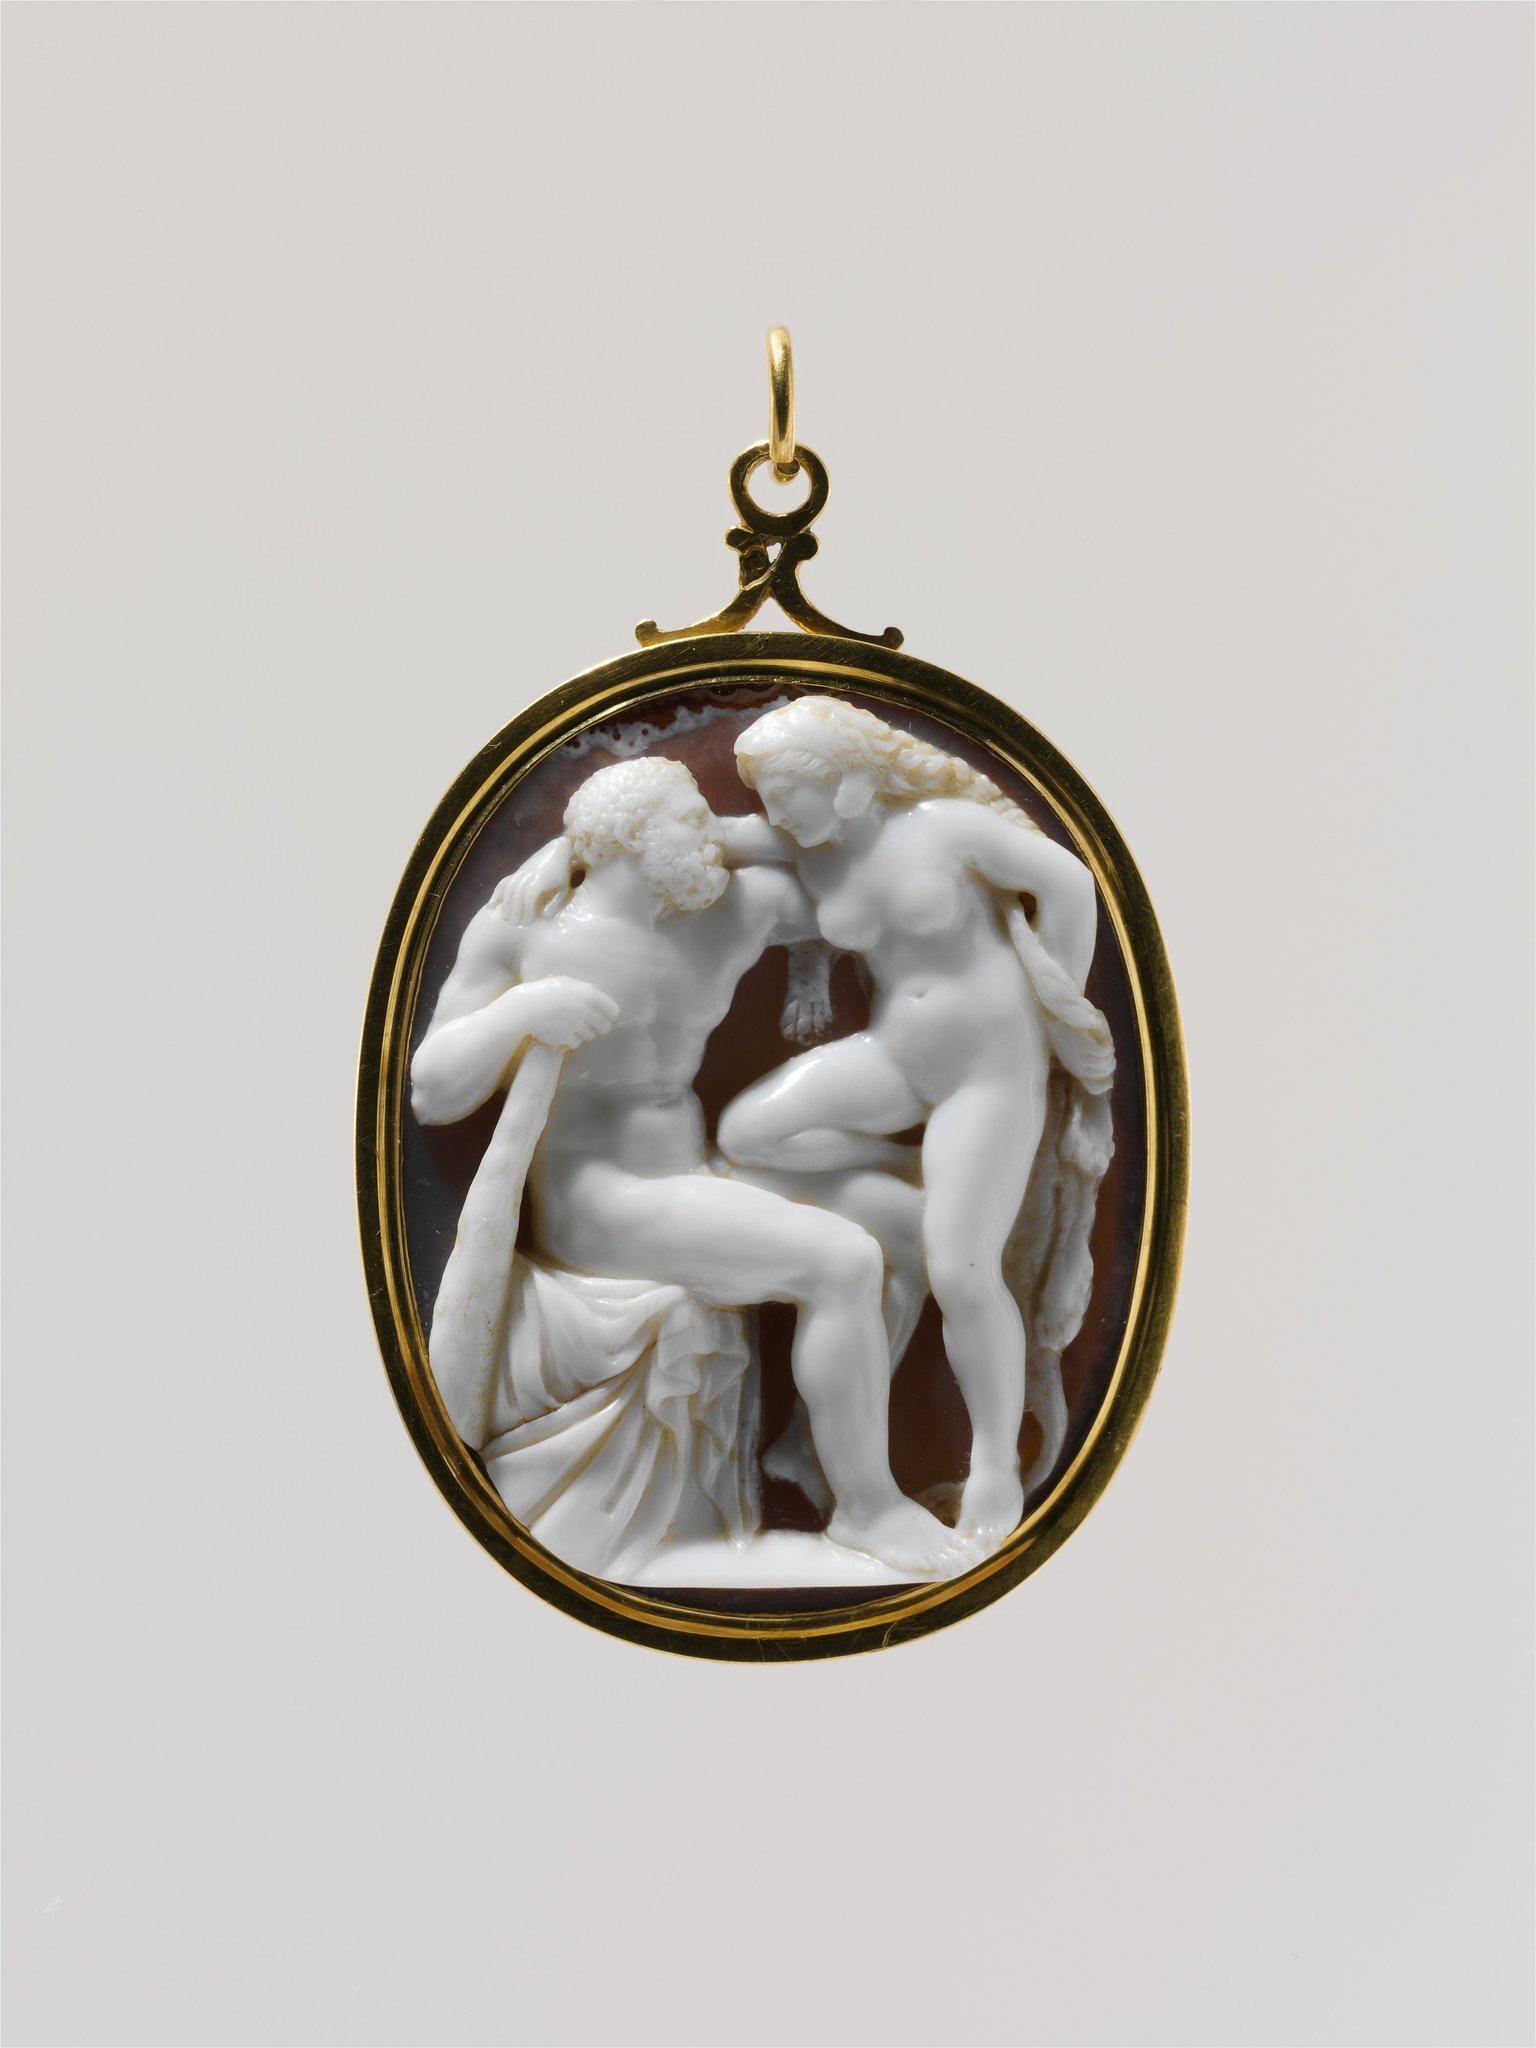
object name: cameo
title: Hercules and Omphale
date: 1667-1733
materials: gold, gemstone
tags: male nudes,female nudes,hercules